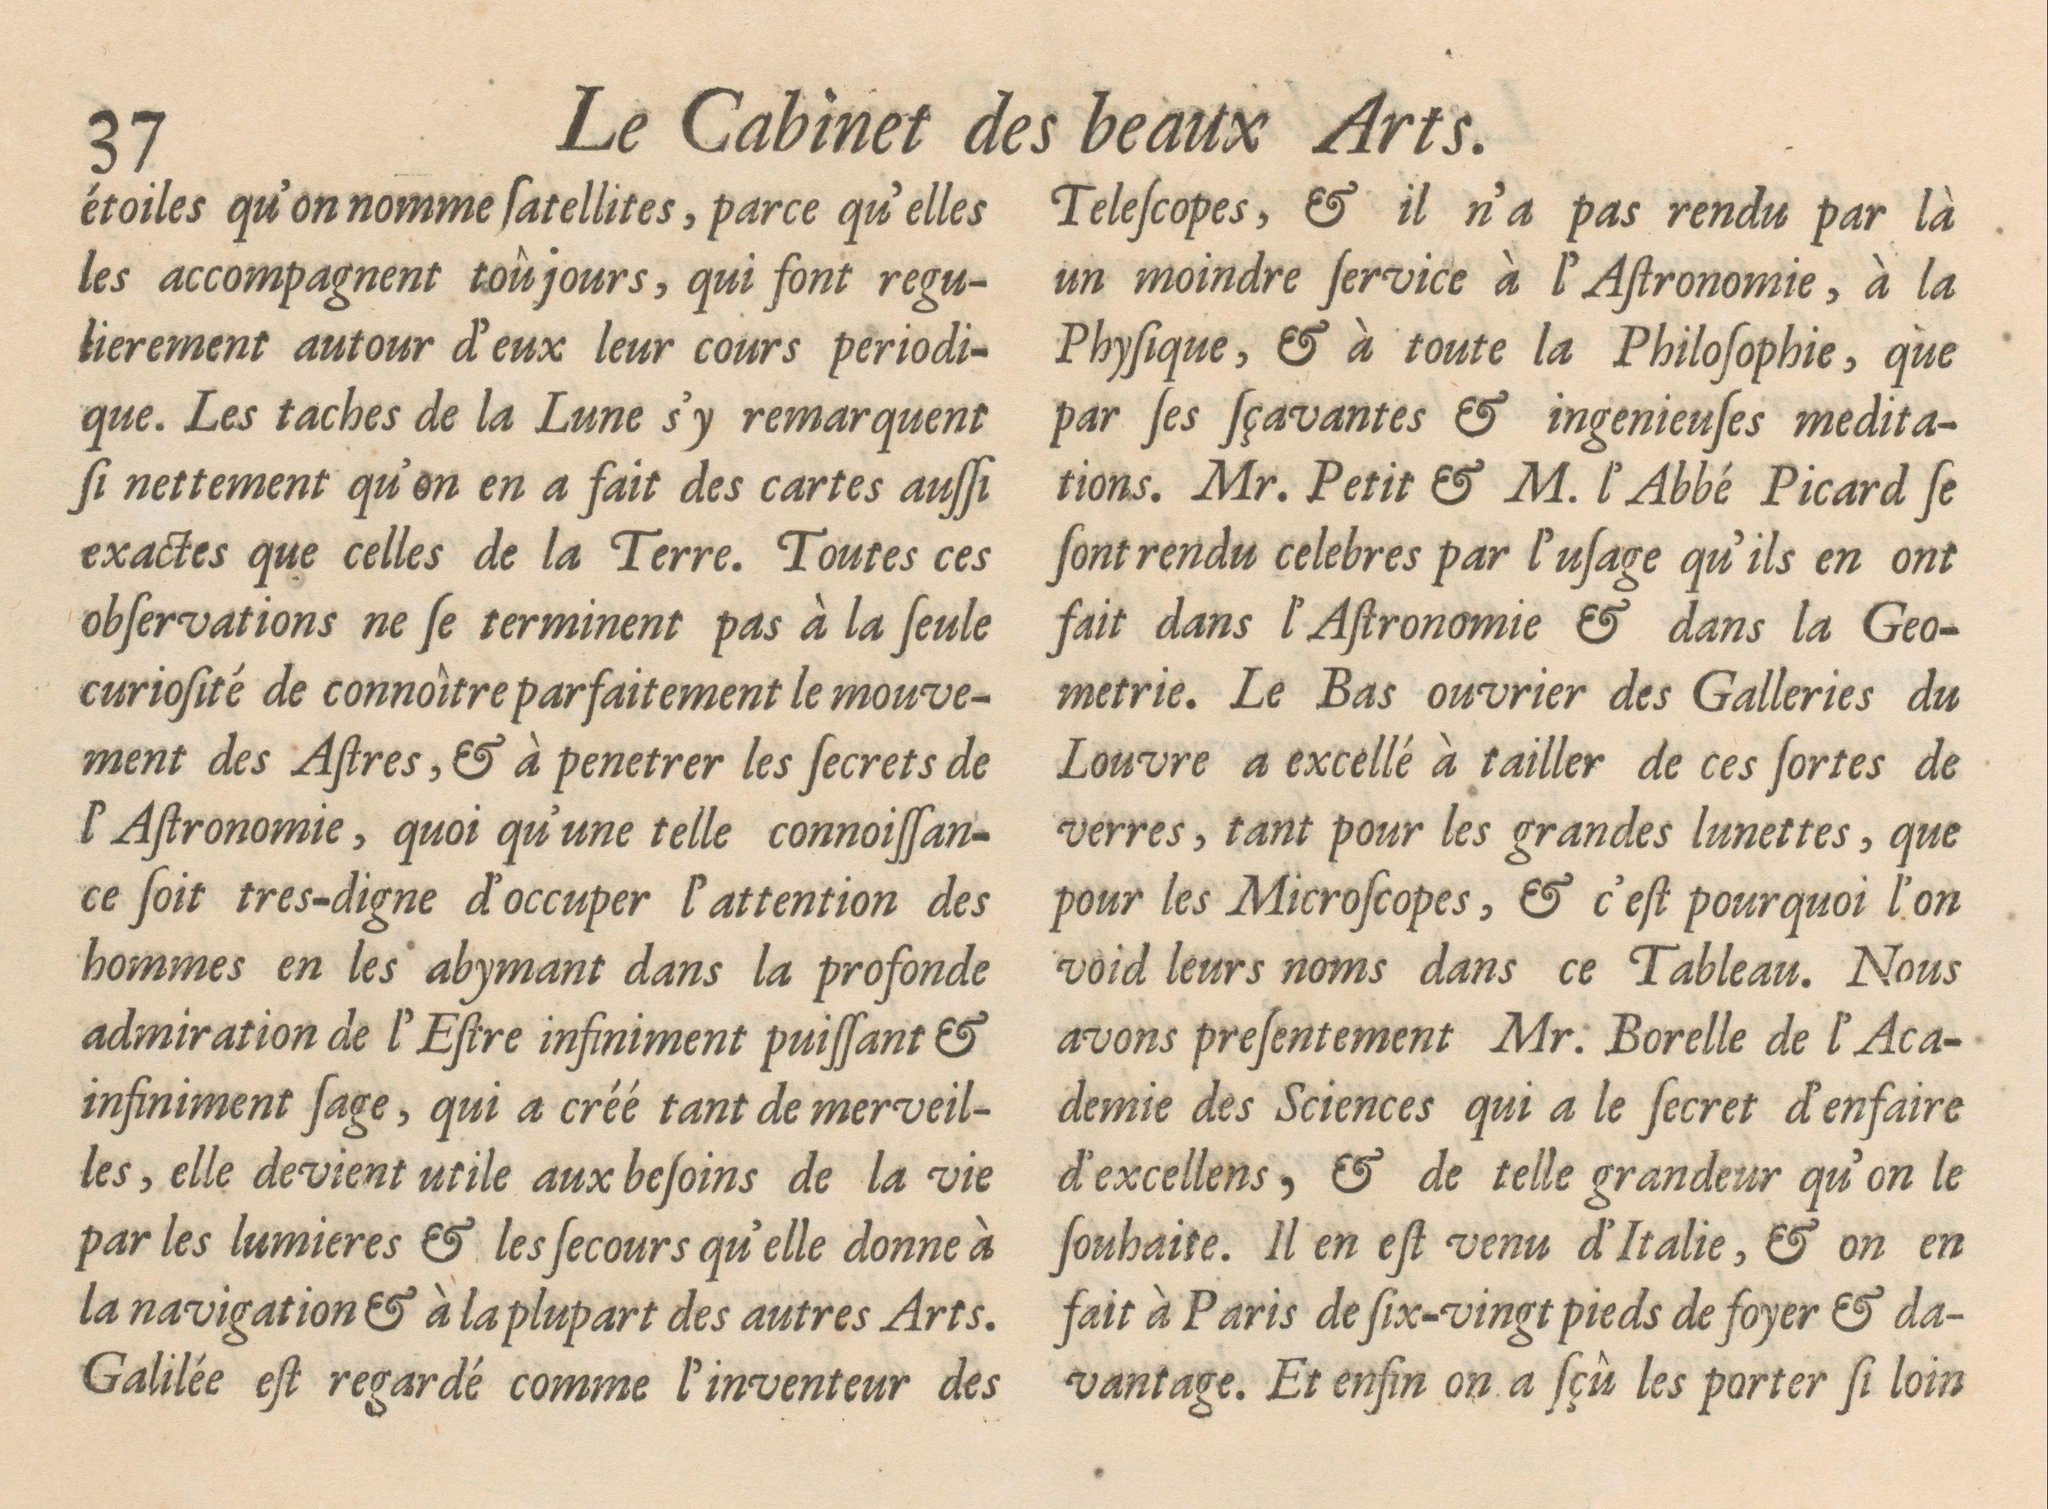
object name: text sheet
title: Tekstblad met verklaring van de prent over Zichtkunde, p. 37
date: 1695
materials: paper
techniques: letterpress printing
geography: paris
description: Verklaring van de prent met voorstelling van Zichtkunde in het Frans. Pagina 37. Tekstblad maakt deel uit van een album.